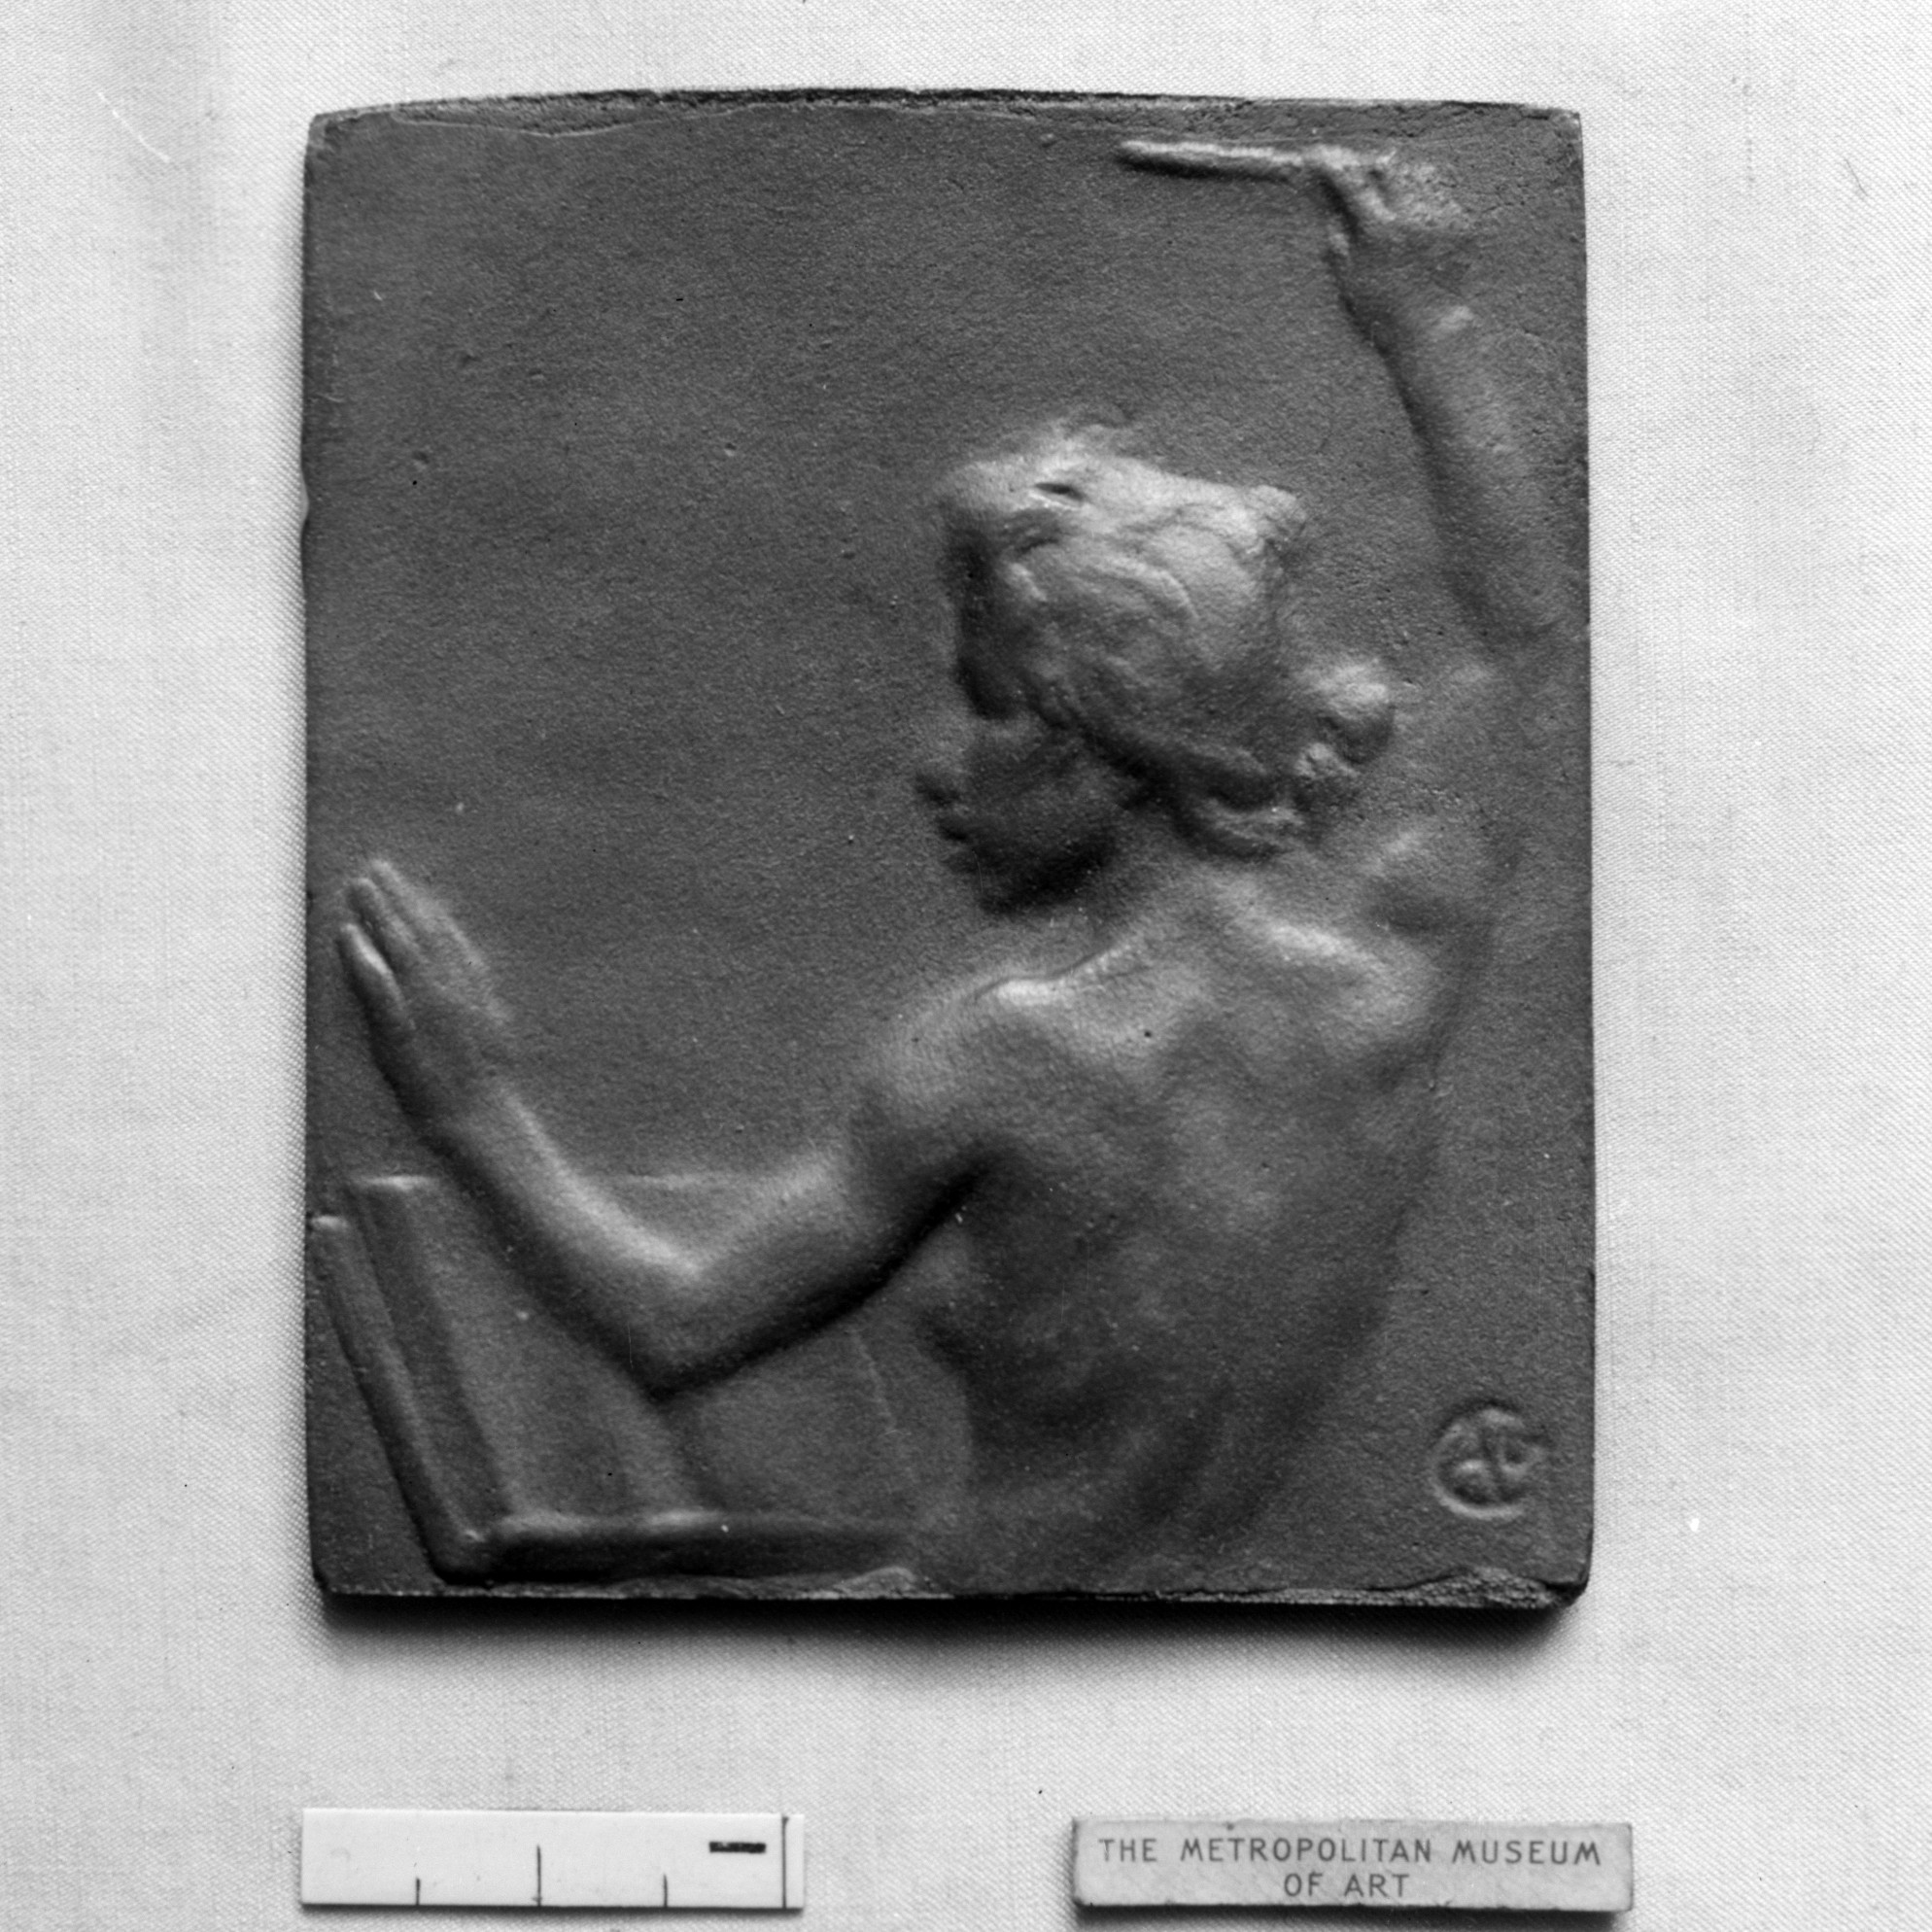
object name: plaquette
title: Woman conducting an orchestra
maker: alexandre-louis-marie charpentier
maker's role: artist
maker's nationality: french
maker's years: 1856-1909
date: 1867-1900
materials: bronze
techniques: casting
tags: women,musicians